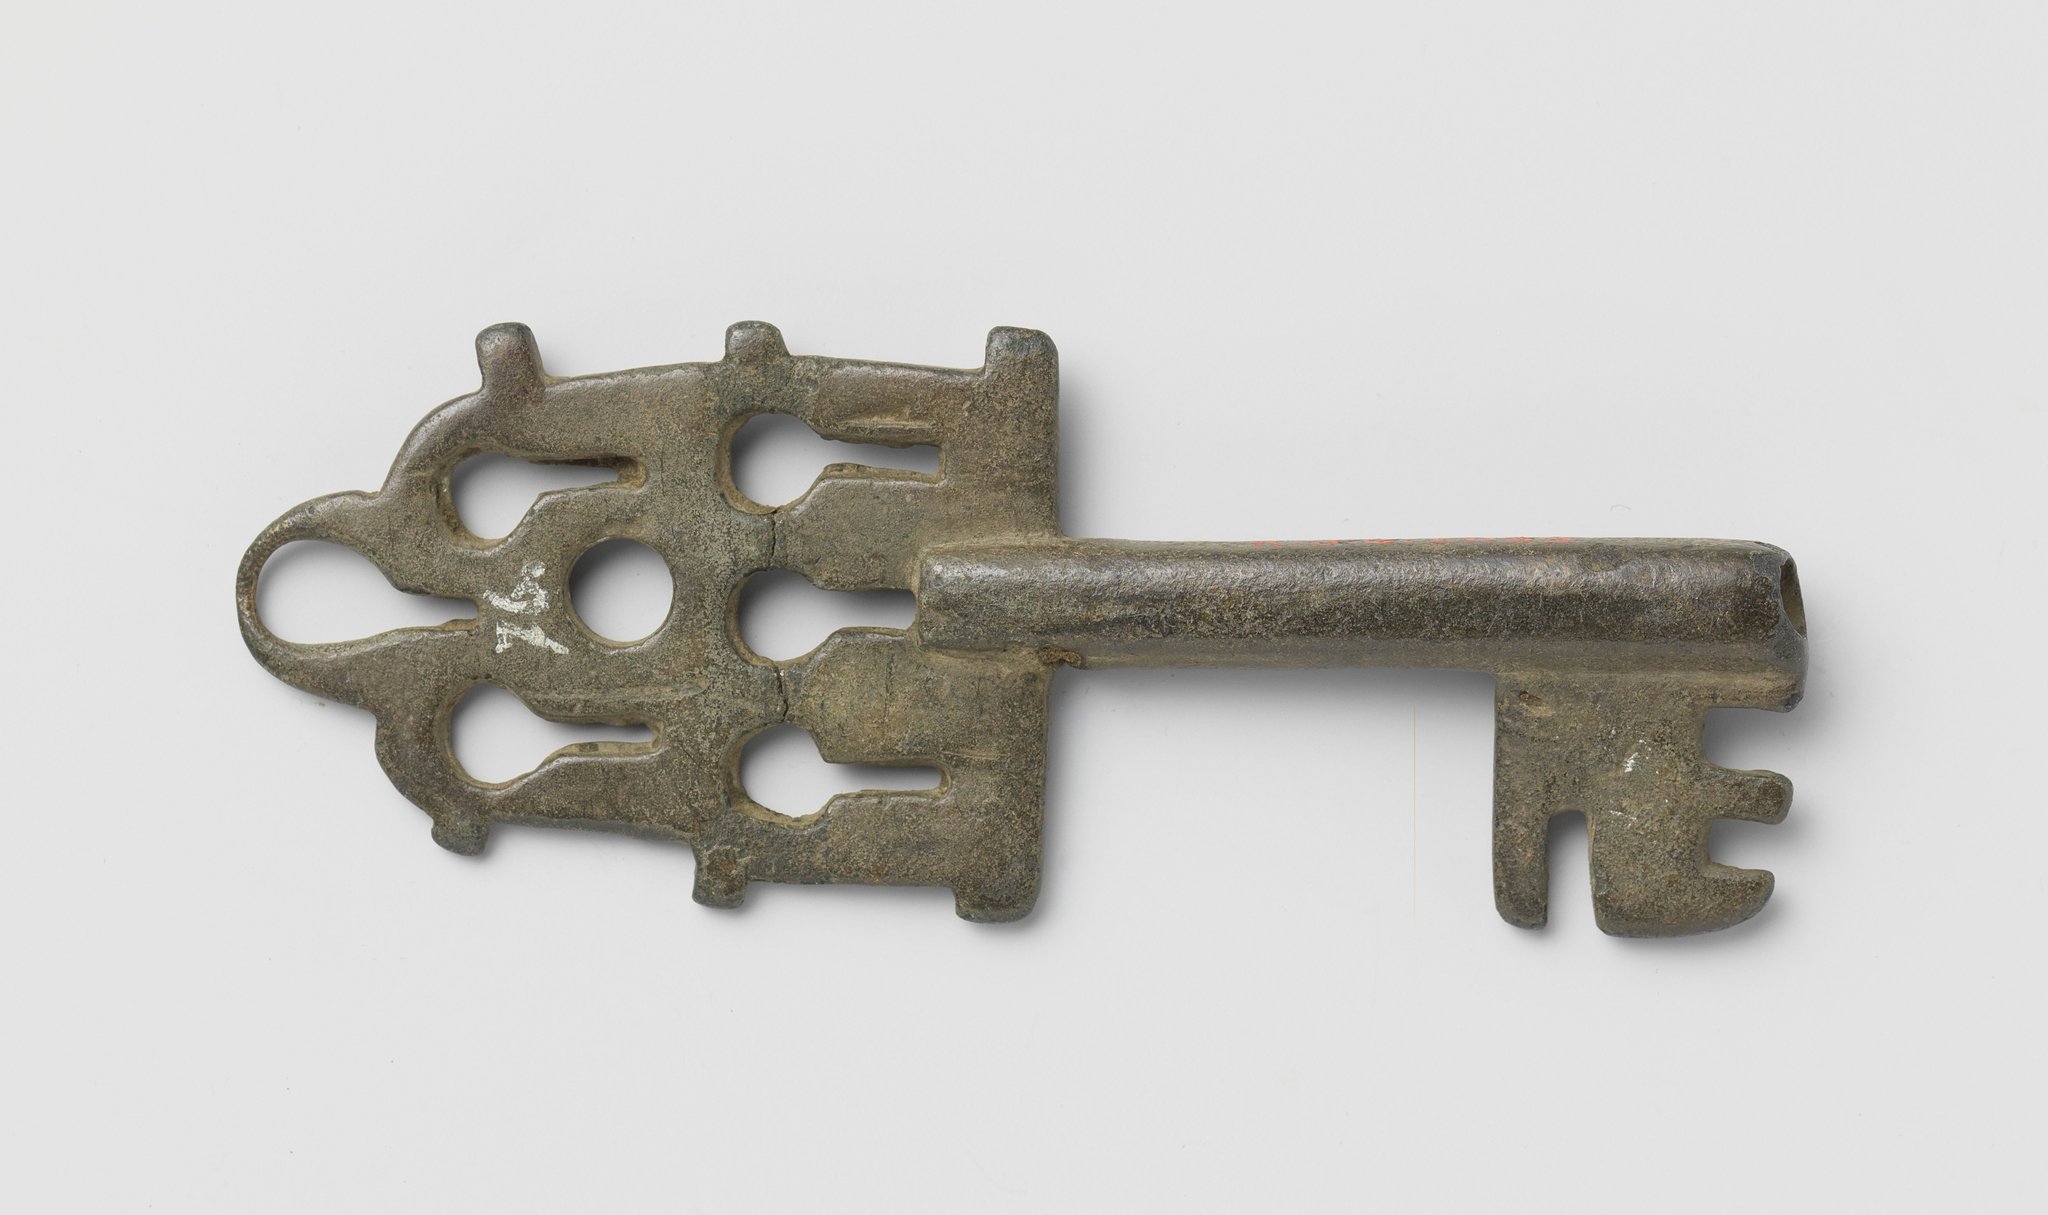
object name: pipe key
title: Bishop’s key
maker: Anonymous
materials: bronze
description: Pijpsleutel, zgn. "bisschopssleutel" waarvan de greep een haanvormige insnijding heeft.